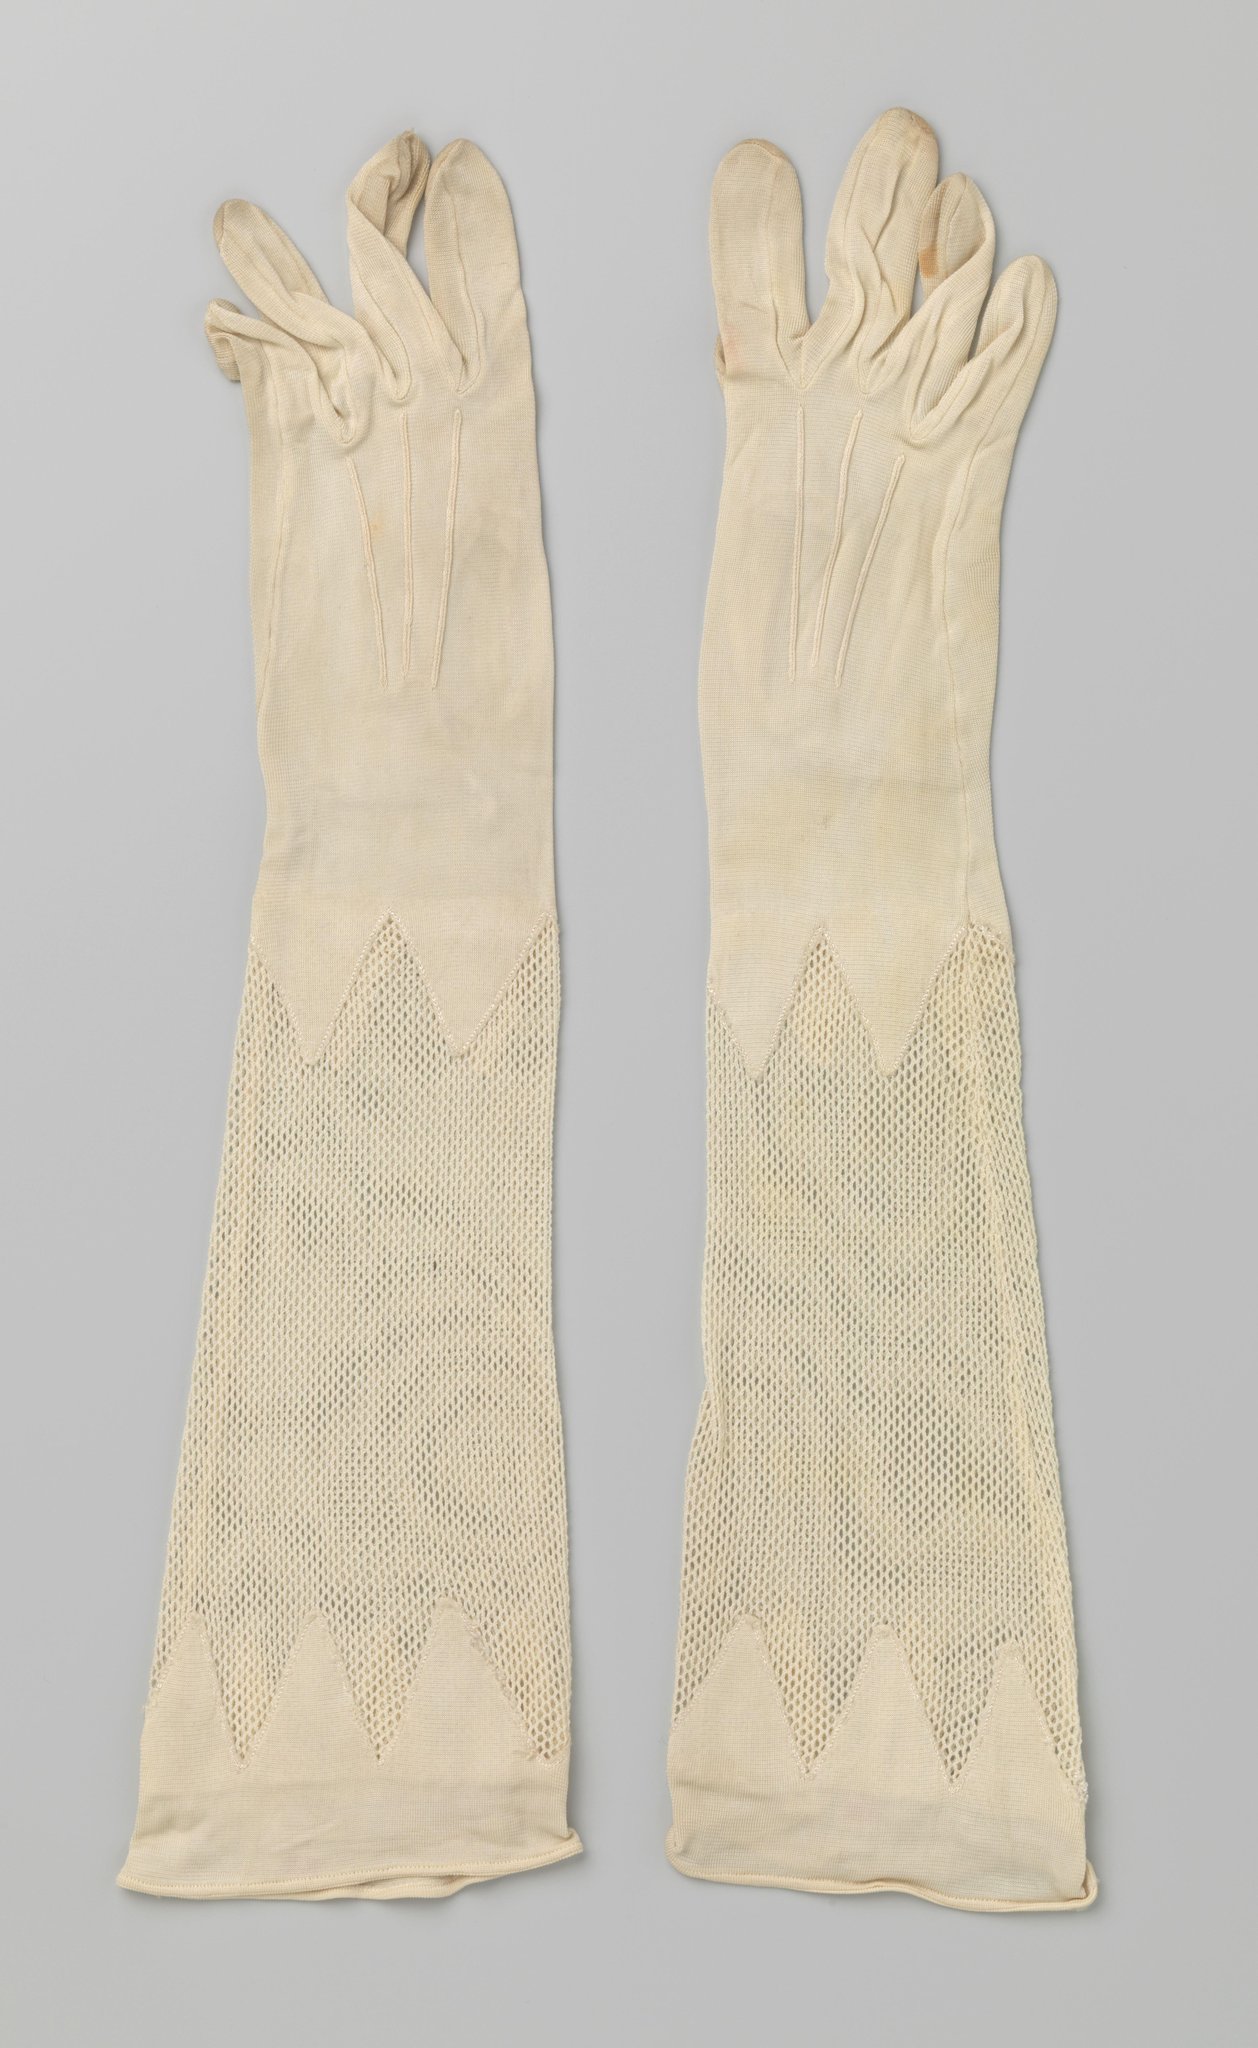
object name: glove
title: Pair of gloves with encrusted crochet design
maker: Anonymous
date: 1910-1915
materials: textile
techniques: crochet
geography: western europe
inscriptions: label: ‘letters’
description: Rechterhandschoen van crèmekleurig rayon. Op de rug drie uitstralende koorden en met machinaal haakwerk.